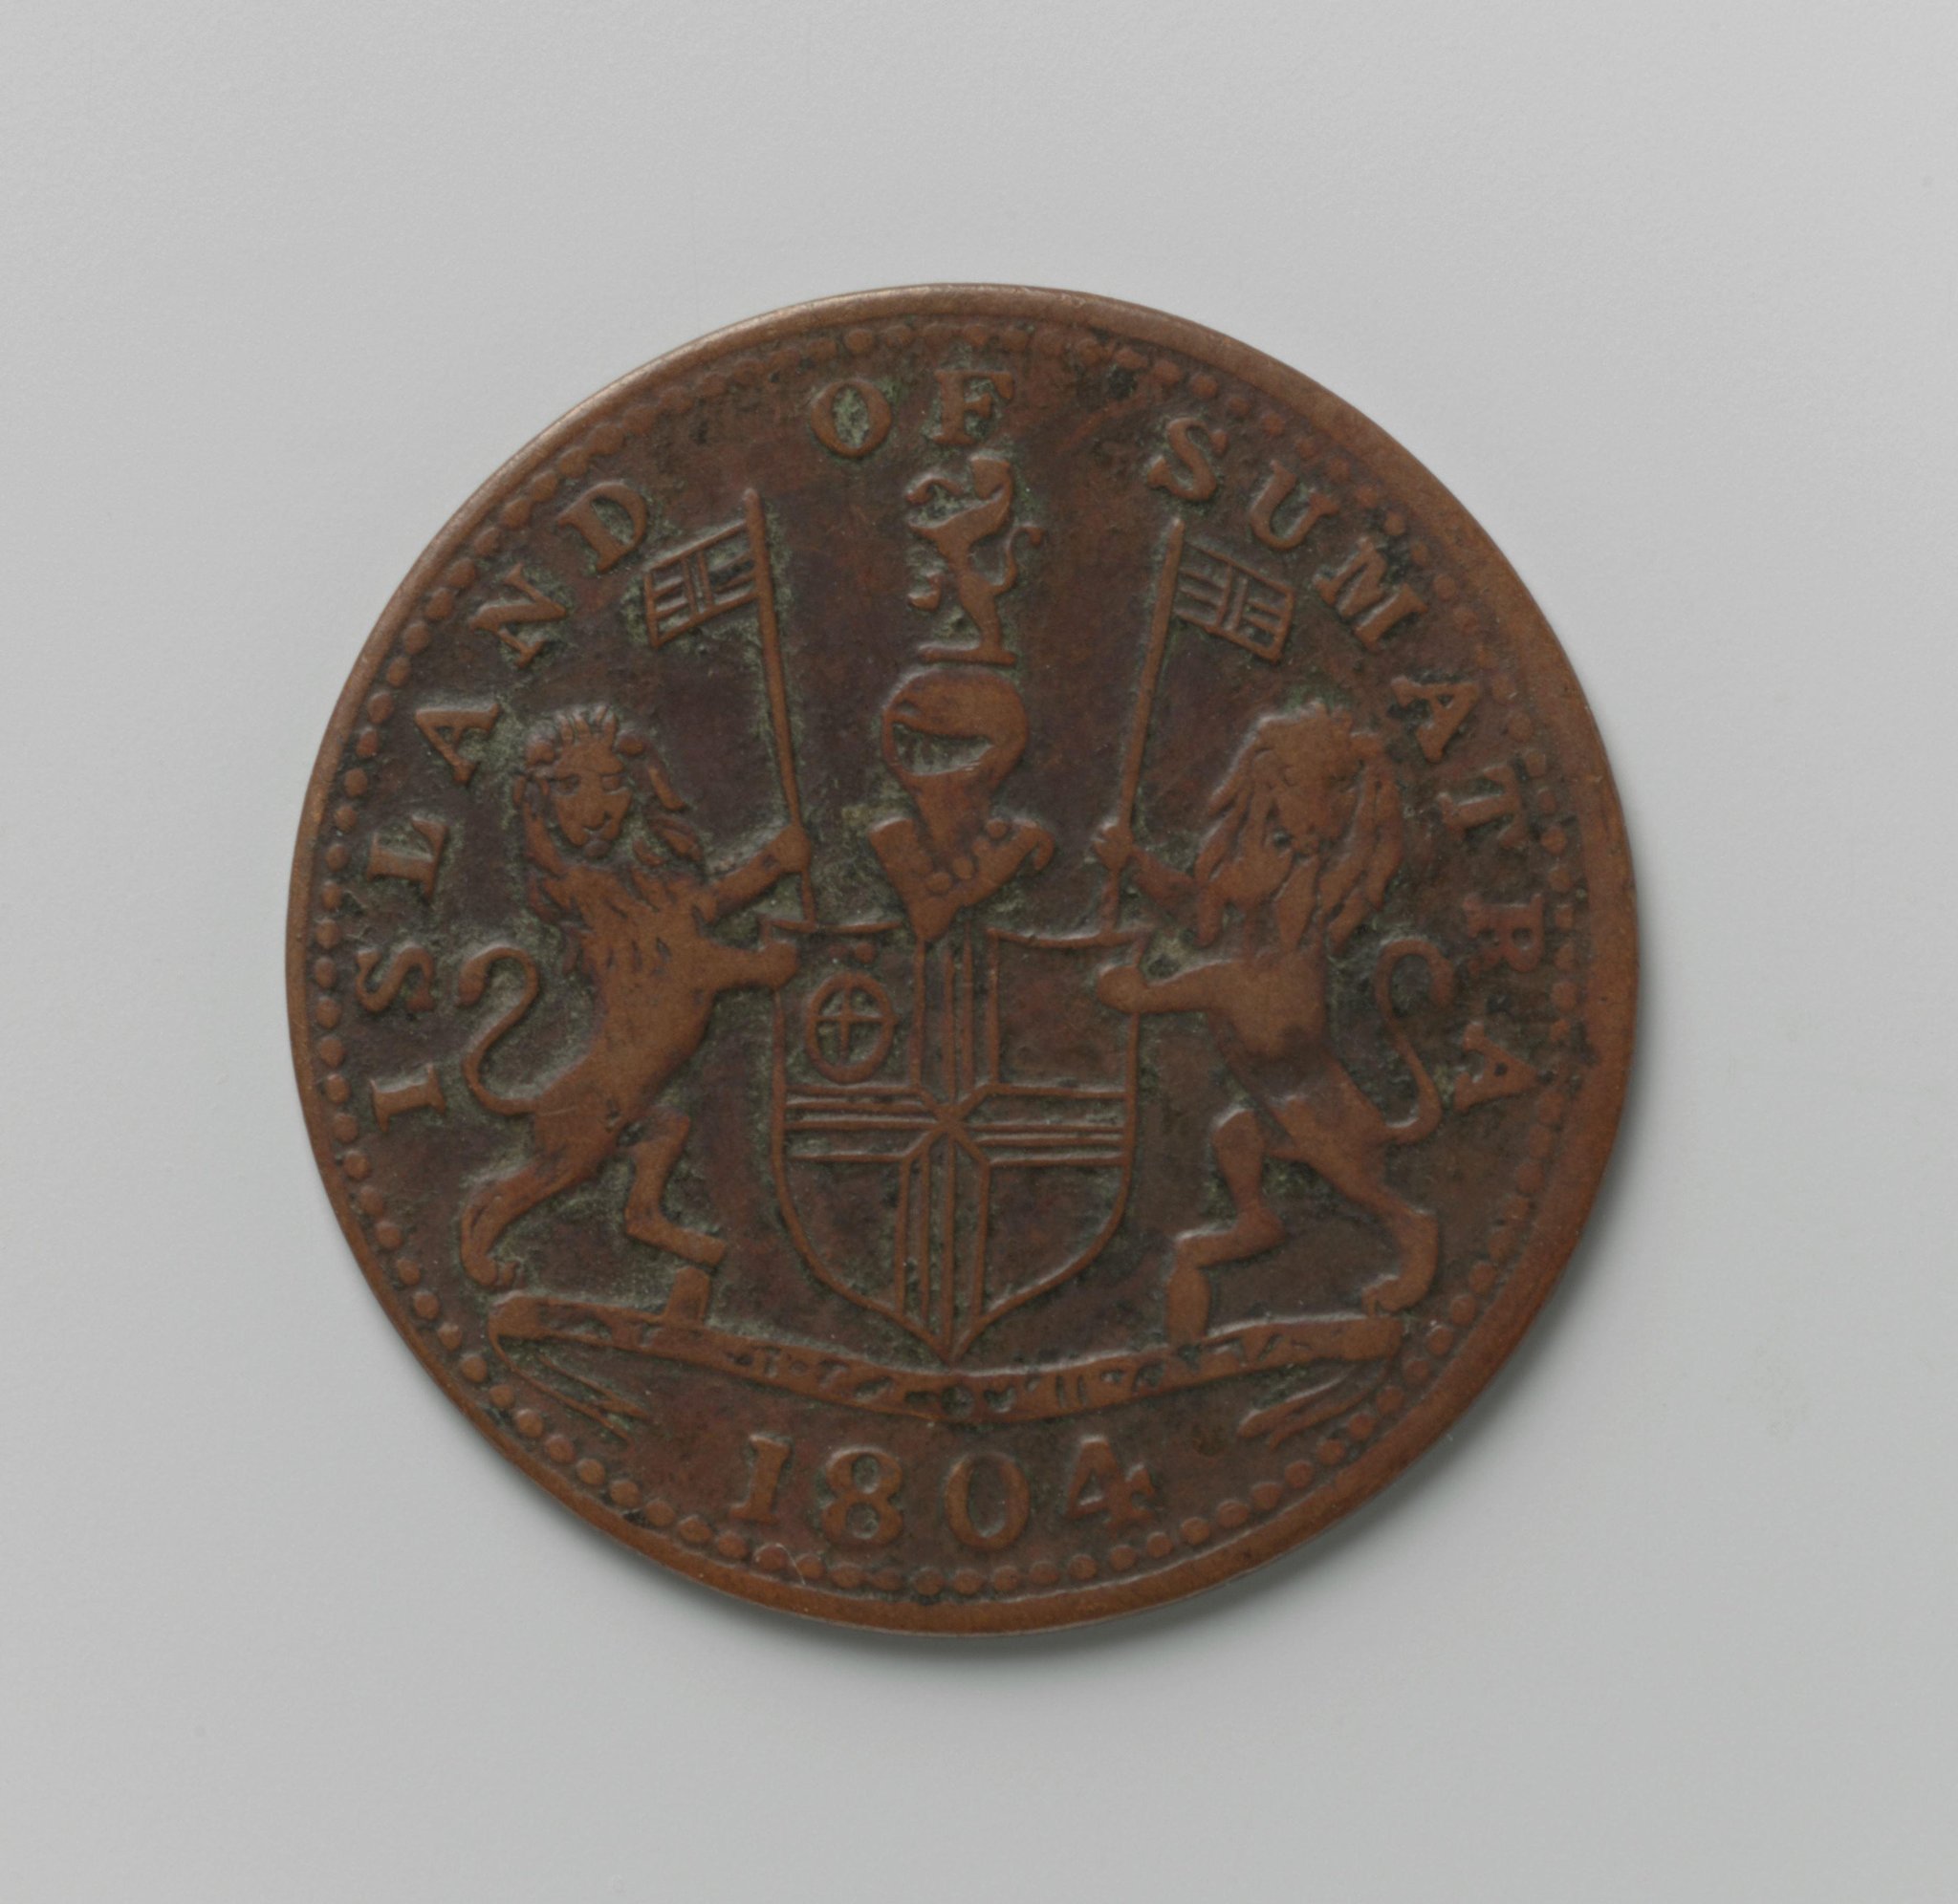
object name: coin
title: Singapore, kepeng,1804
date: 1831-1844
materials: copper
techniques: striking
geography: birmingham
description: Koperen munt. Voorzijde: door twee leeuwen gehouden wapenschild van de Engelse Oostindische Compagnie, waarboven aanduiding Island of Sumatra en waaronder wapenspreuk. Daaronder bevroren jaartal 1804. Keerzijde: op een regel in het Maleis waarde-aanduiding: satoe kepeng. Daarboven cijfer: 1 in Arabische cijfers en daaronder jaartal in Islamitische tijdsrekening en in Arabische cijfers:1247. Gladde rand.